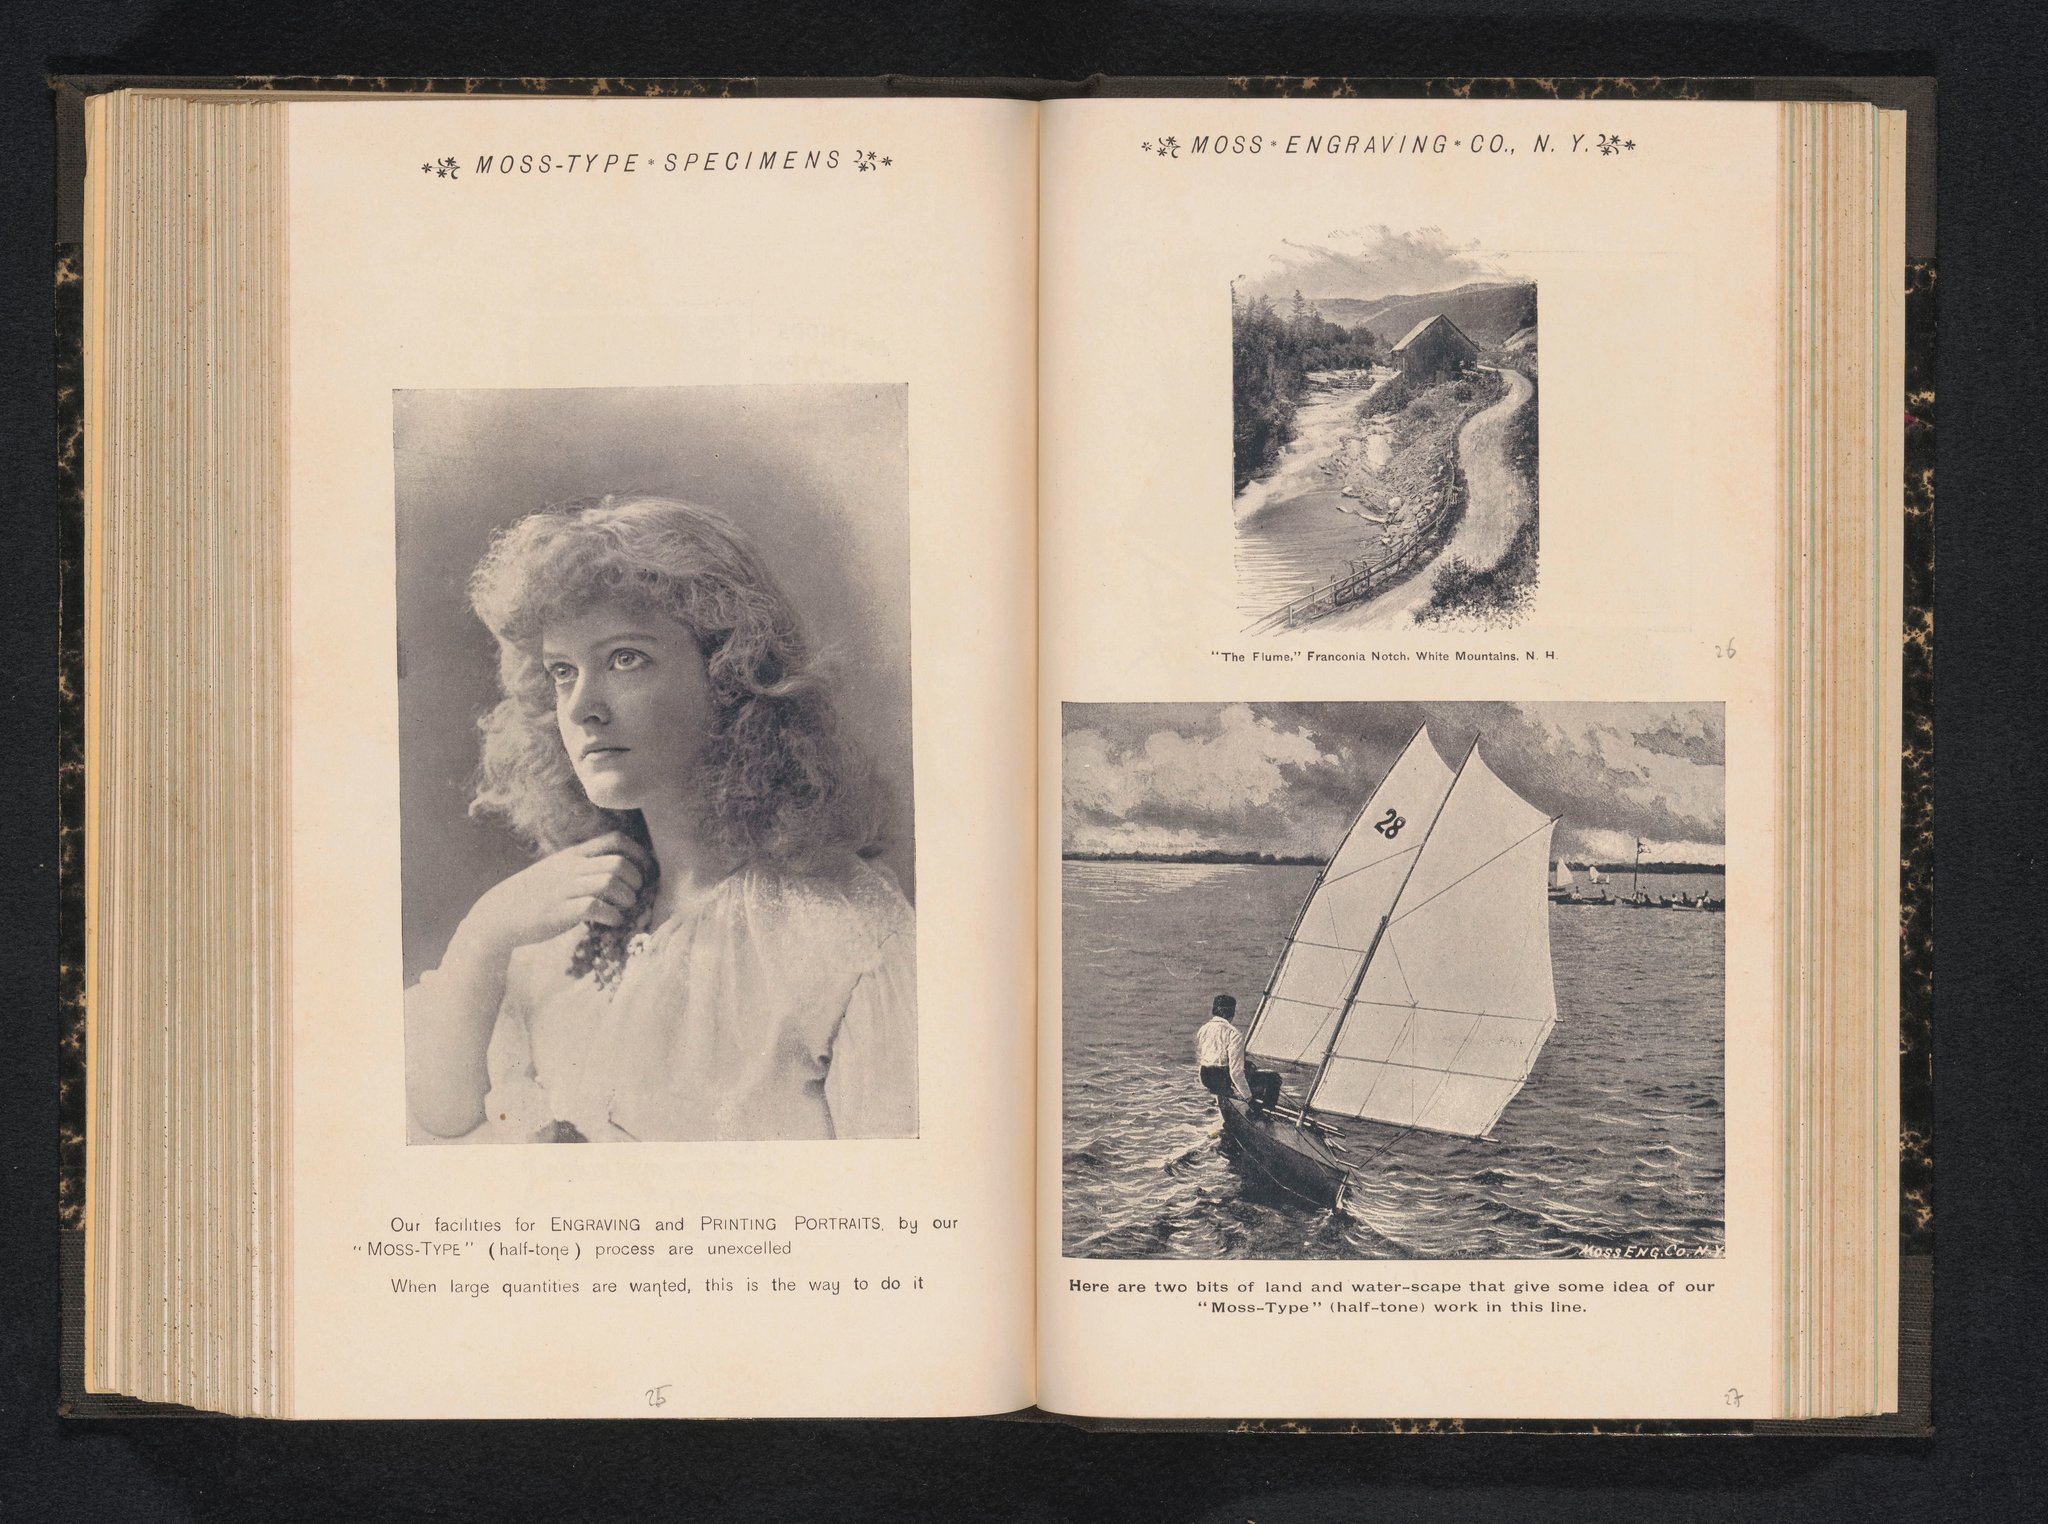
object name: photomechanical print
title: Gezicht op de Flume kloof in het Franconia Notch State Park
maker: Anonymous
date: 1887-1907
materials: paper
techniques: autotype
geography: franconia notch state park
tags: river, mountains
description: Prent op vierde ongenummerde pagina na pagina 393.